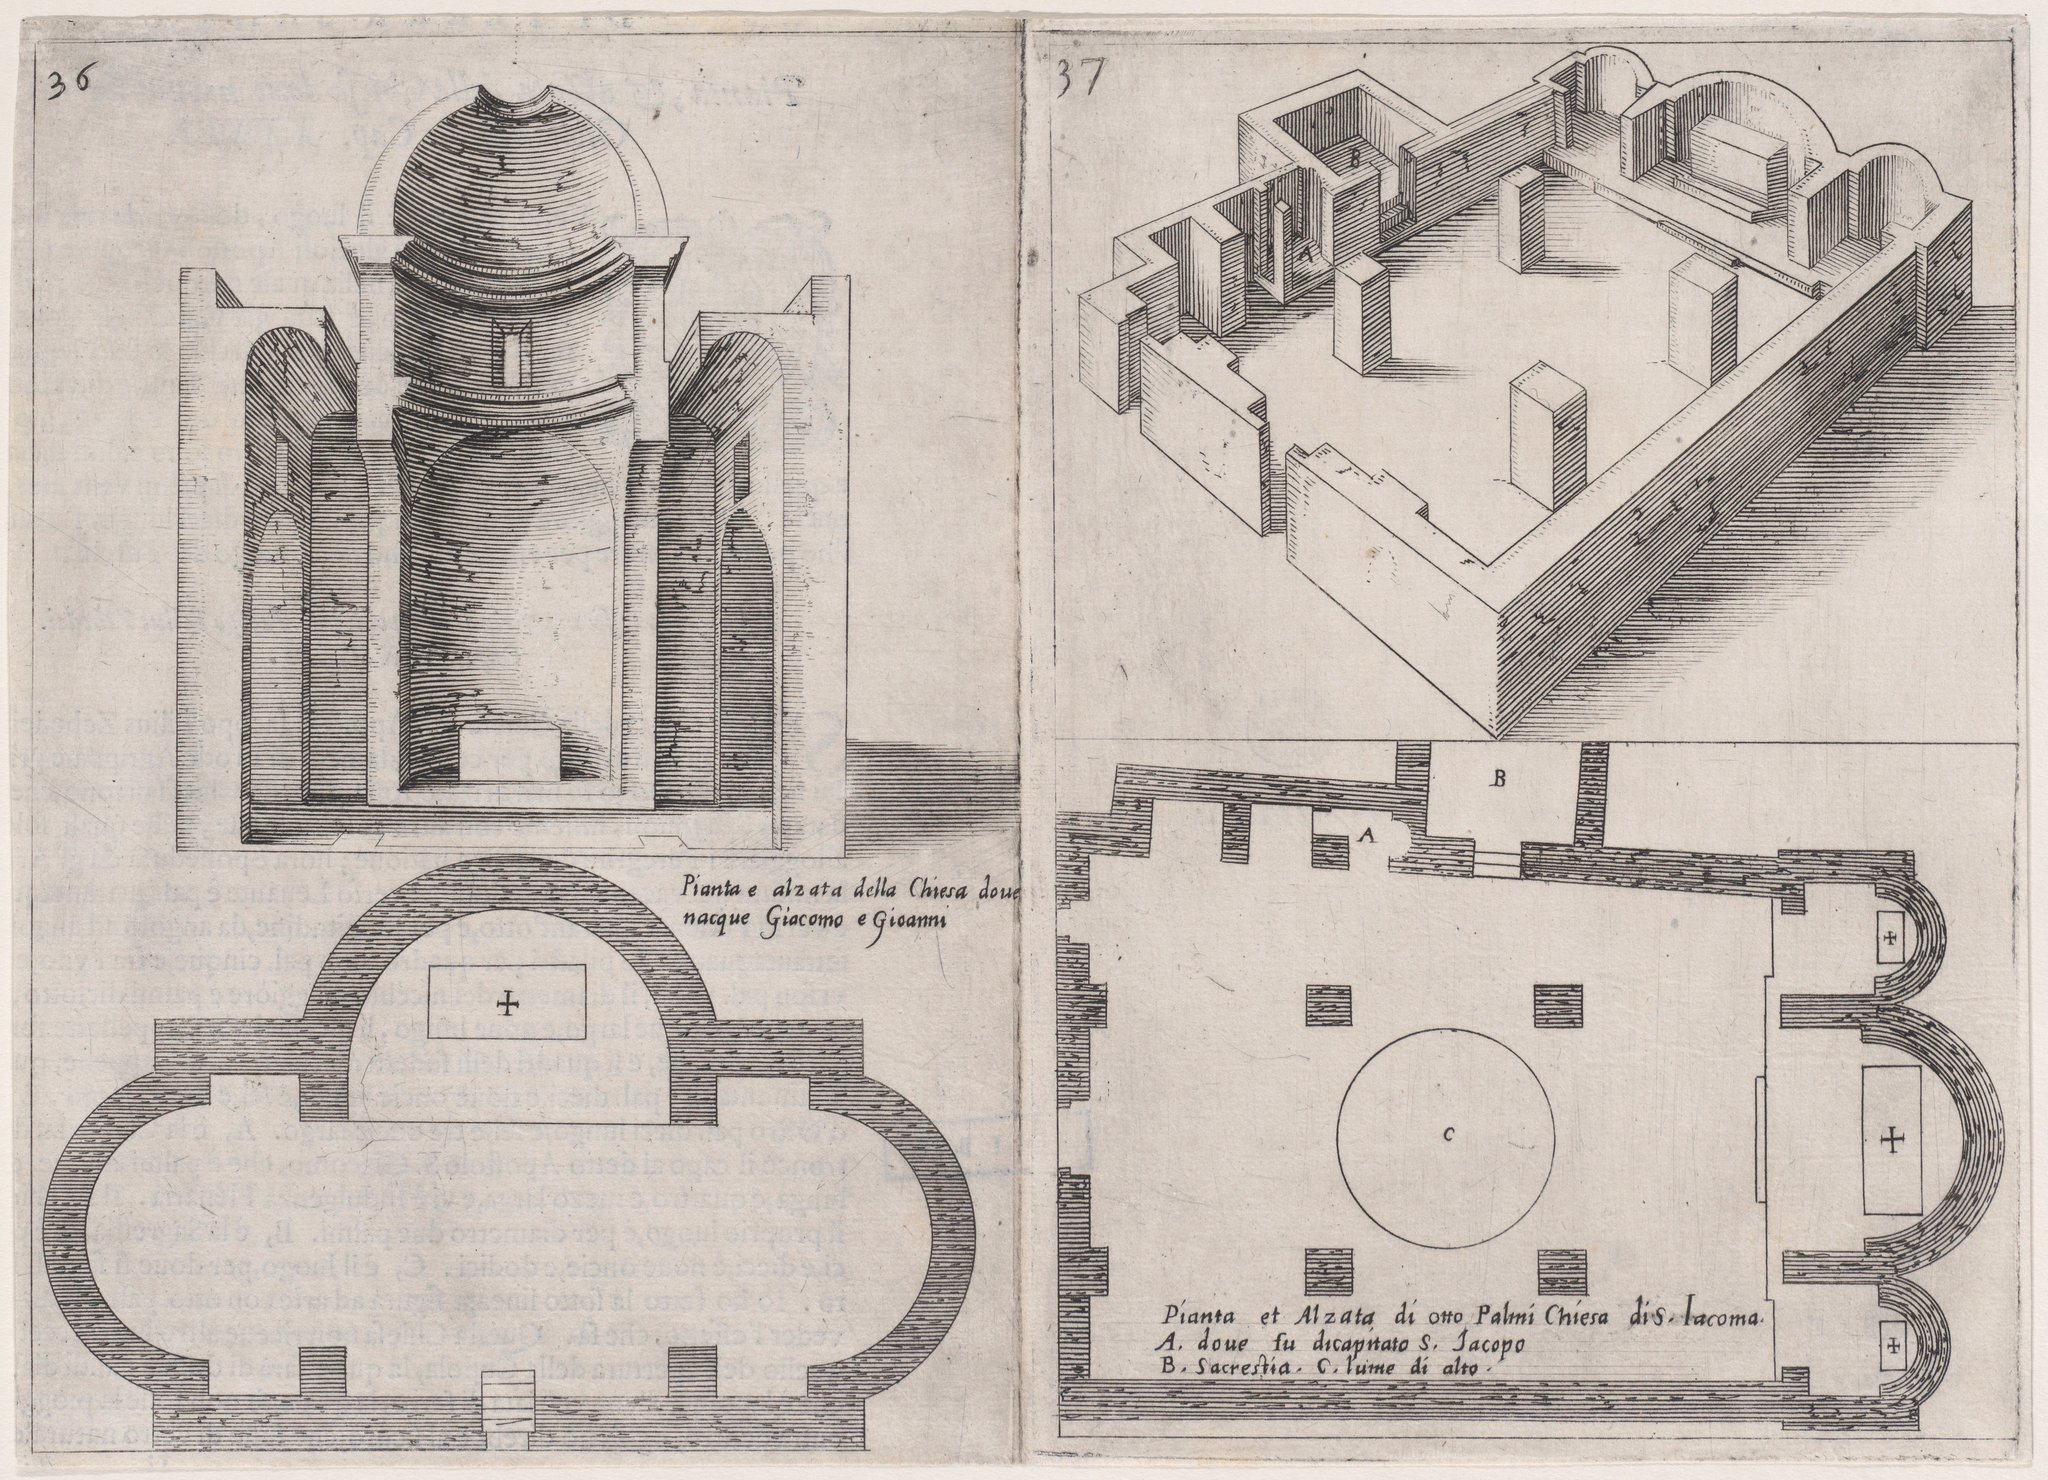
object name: print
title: Plates 29 and 30, from "Trattato delle Piante & Immagini de Sacri Edifizi di Terra Santa" (Treatise of the Plans & Images of the Sacred Buildings of the Holy Land)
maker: jacques callot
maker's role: artist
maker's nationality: french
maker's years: 1592-1635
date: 1620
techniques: engraving, etching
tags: architecture,buildings